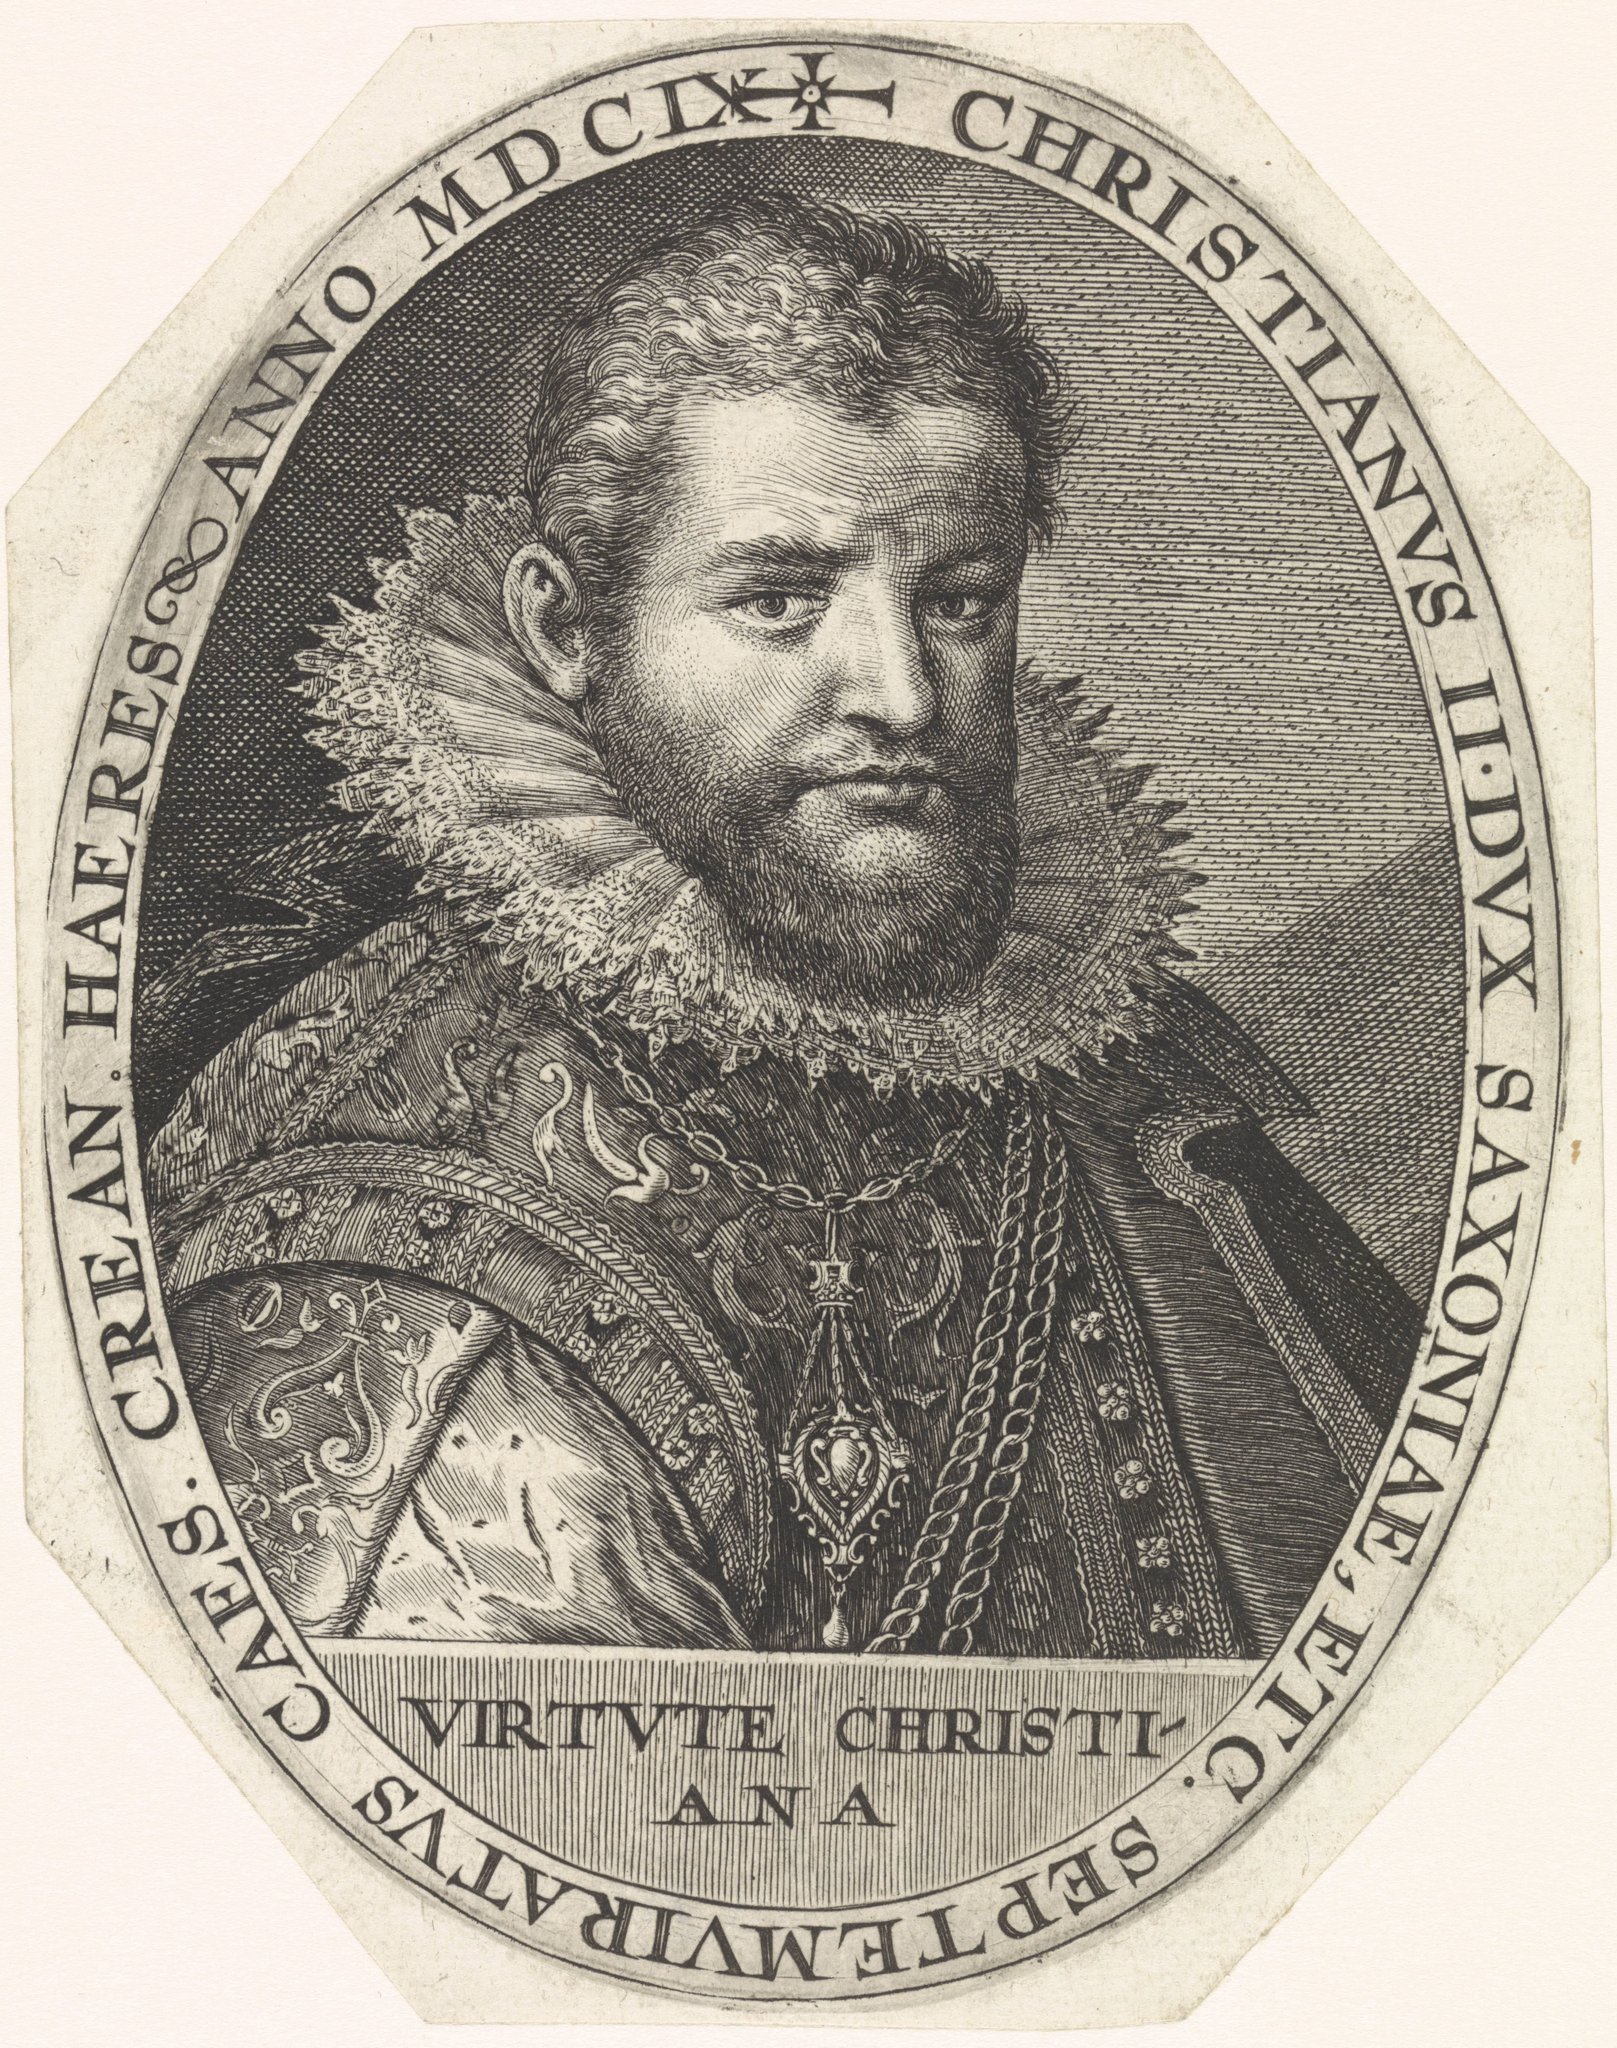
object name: print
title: Portret van Christiaan II van Saksen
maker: crispijn van de passe (i)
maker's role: draughtsman, print maker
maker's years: 1564-1637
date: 1609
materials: paper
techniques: engraving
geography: cologne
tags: keurvorst, christiaan ii van saksen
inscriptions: collector's mark: Lugt 2228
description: Portret van Christiaan II van Saksen, eronder zijn devies in het Latijn. Hij volgde in 1591 zijn vader Christiaan I van Saksen als keurvorst op, maar stond tot 1601 onder voogdij.